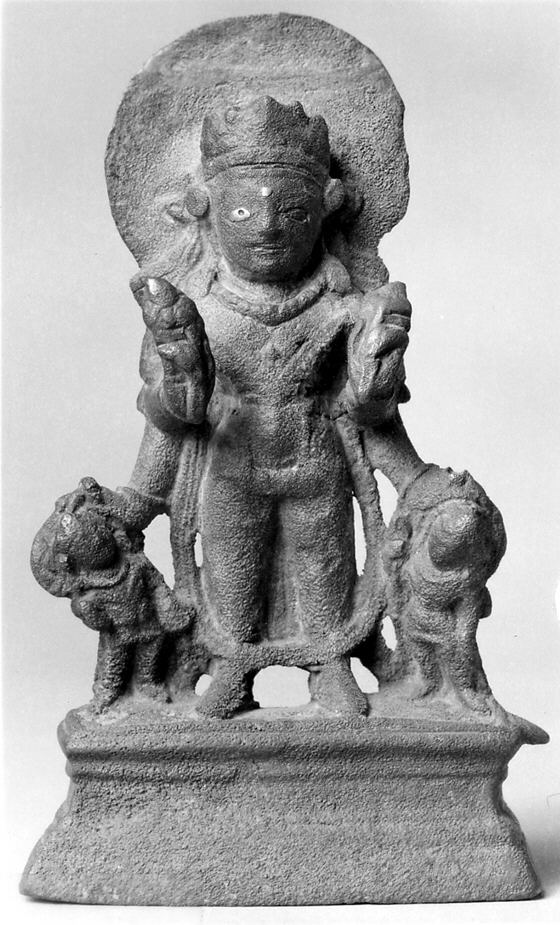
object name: group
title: Surya (The God of the Sun) with Attendants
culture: kashmiri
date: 601-700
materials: bronze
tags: kashmir,hinduism